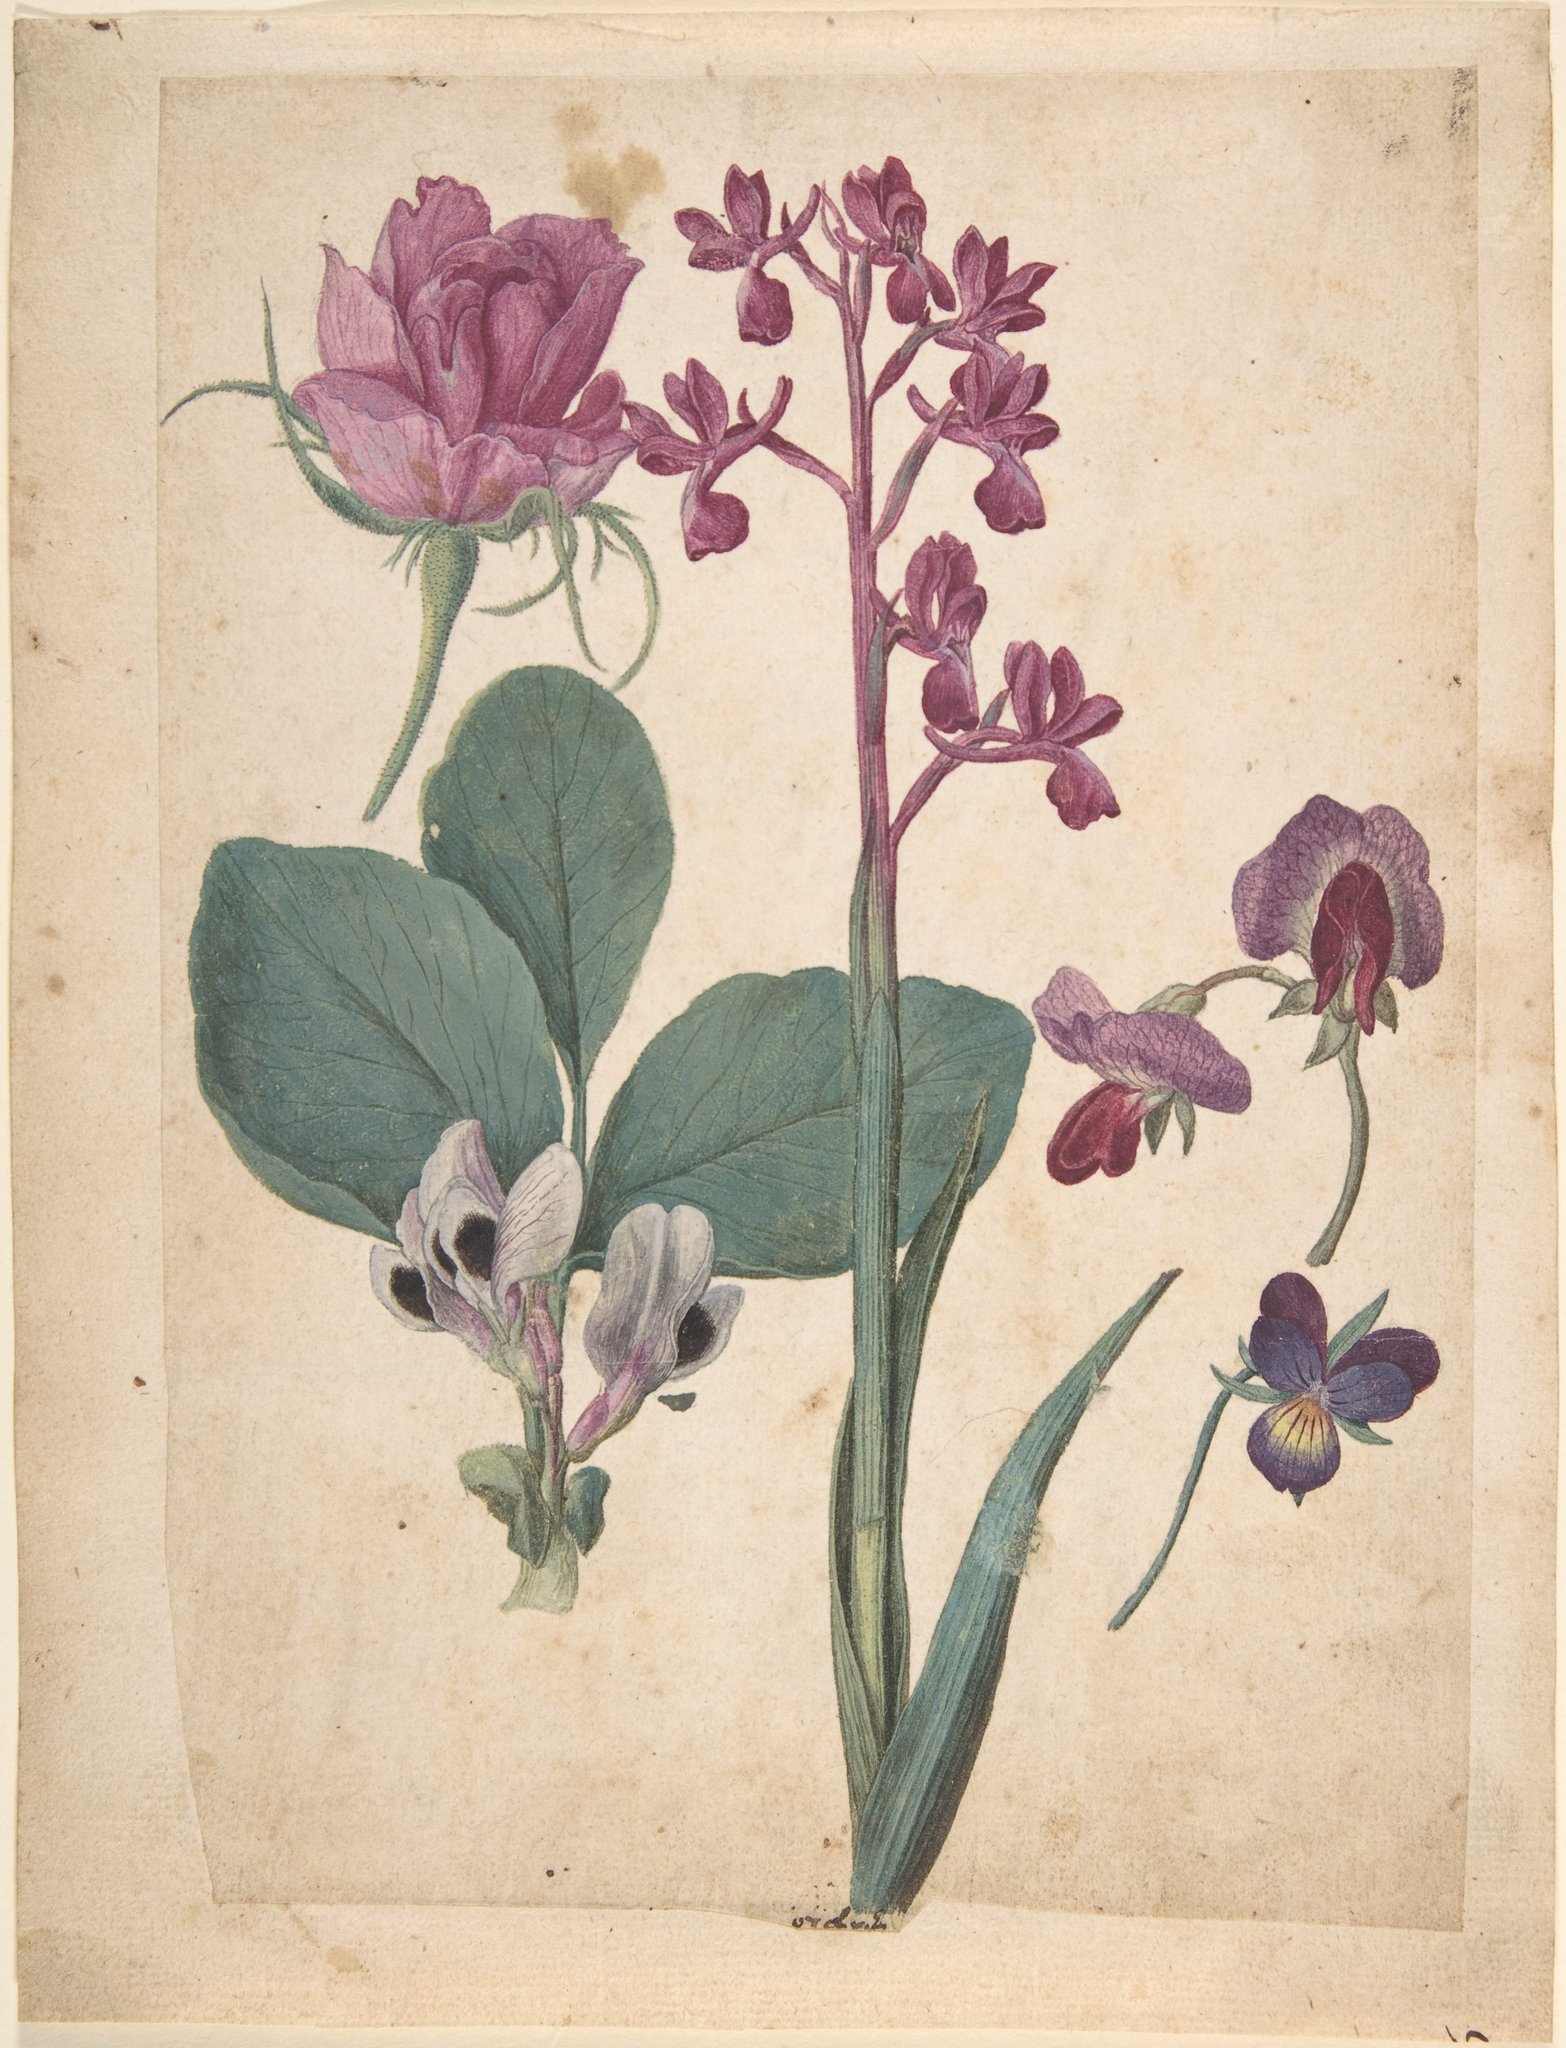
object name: drawing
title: A Sheet of Studies of Flowers: A Rose, a Heartsease, a Sweet Pea, a Garden Pea, and a Lax-flowered Orchid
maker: jacques le moyne de morgues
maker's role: artist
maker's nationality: french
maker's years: 1533-1588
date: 1501-1600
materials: chalk, gouache, watercolor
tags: orchids,roses